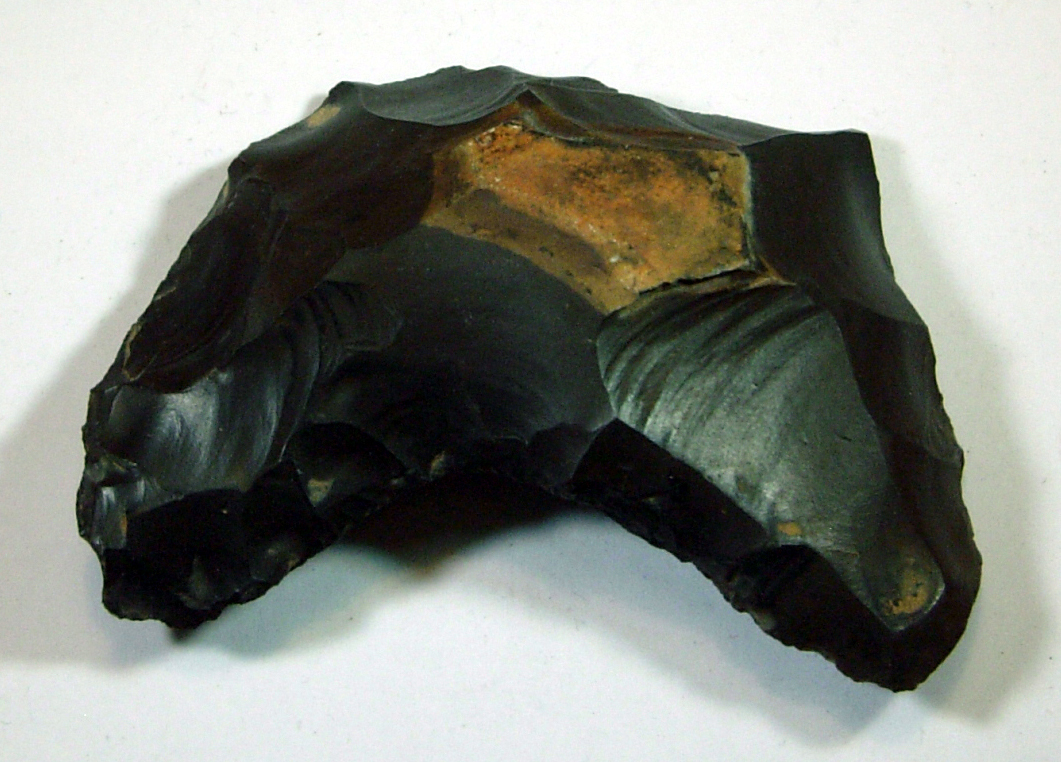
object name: tool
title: Tool (?)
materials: stone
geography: egypt